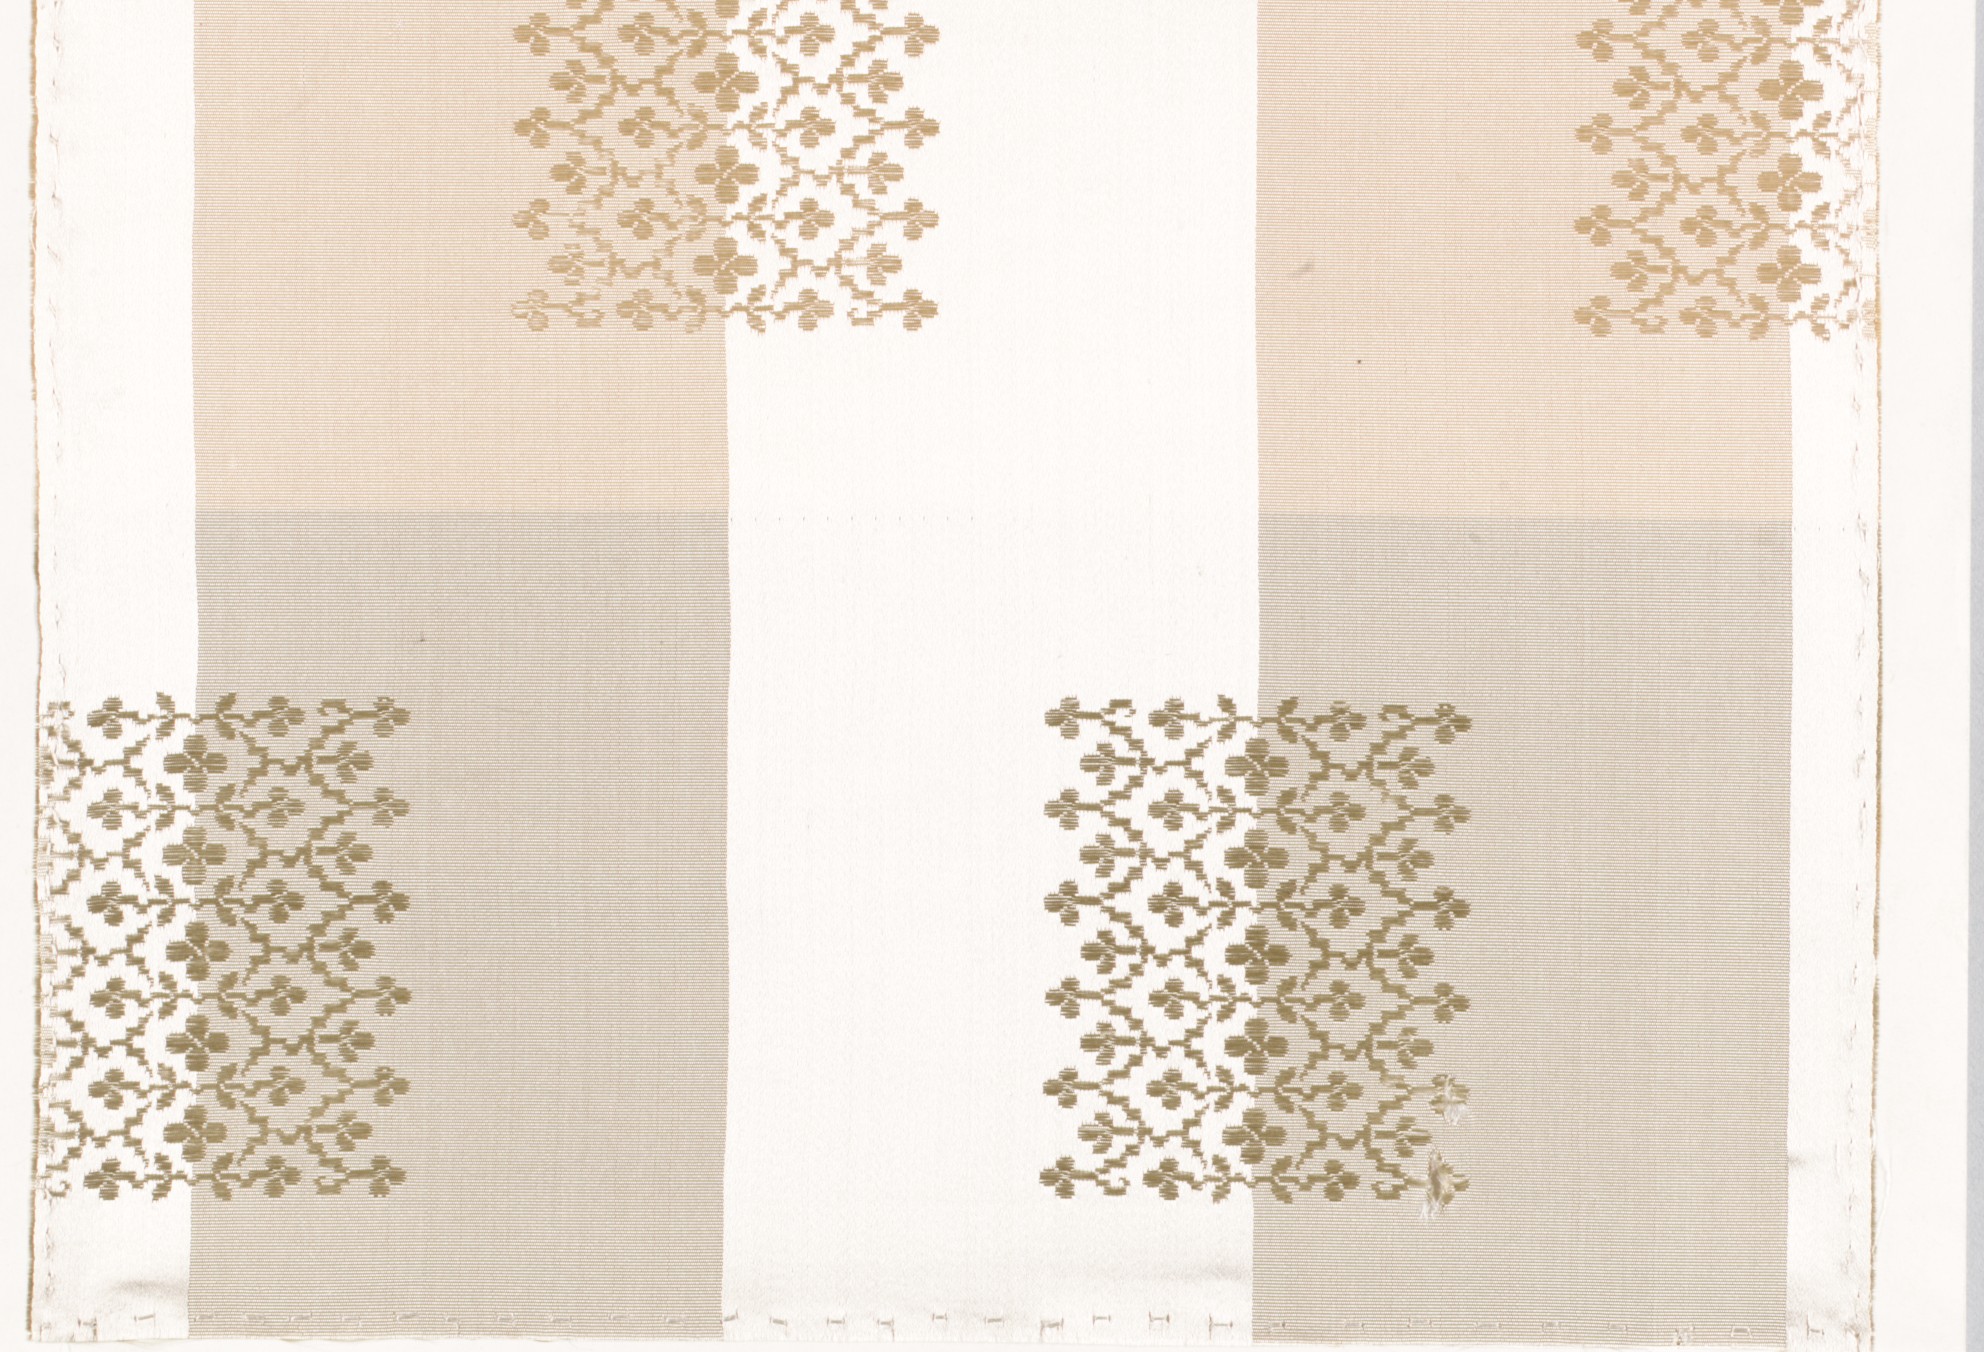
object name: textile sample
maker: Anonymous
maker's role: designer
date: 1900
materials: silk